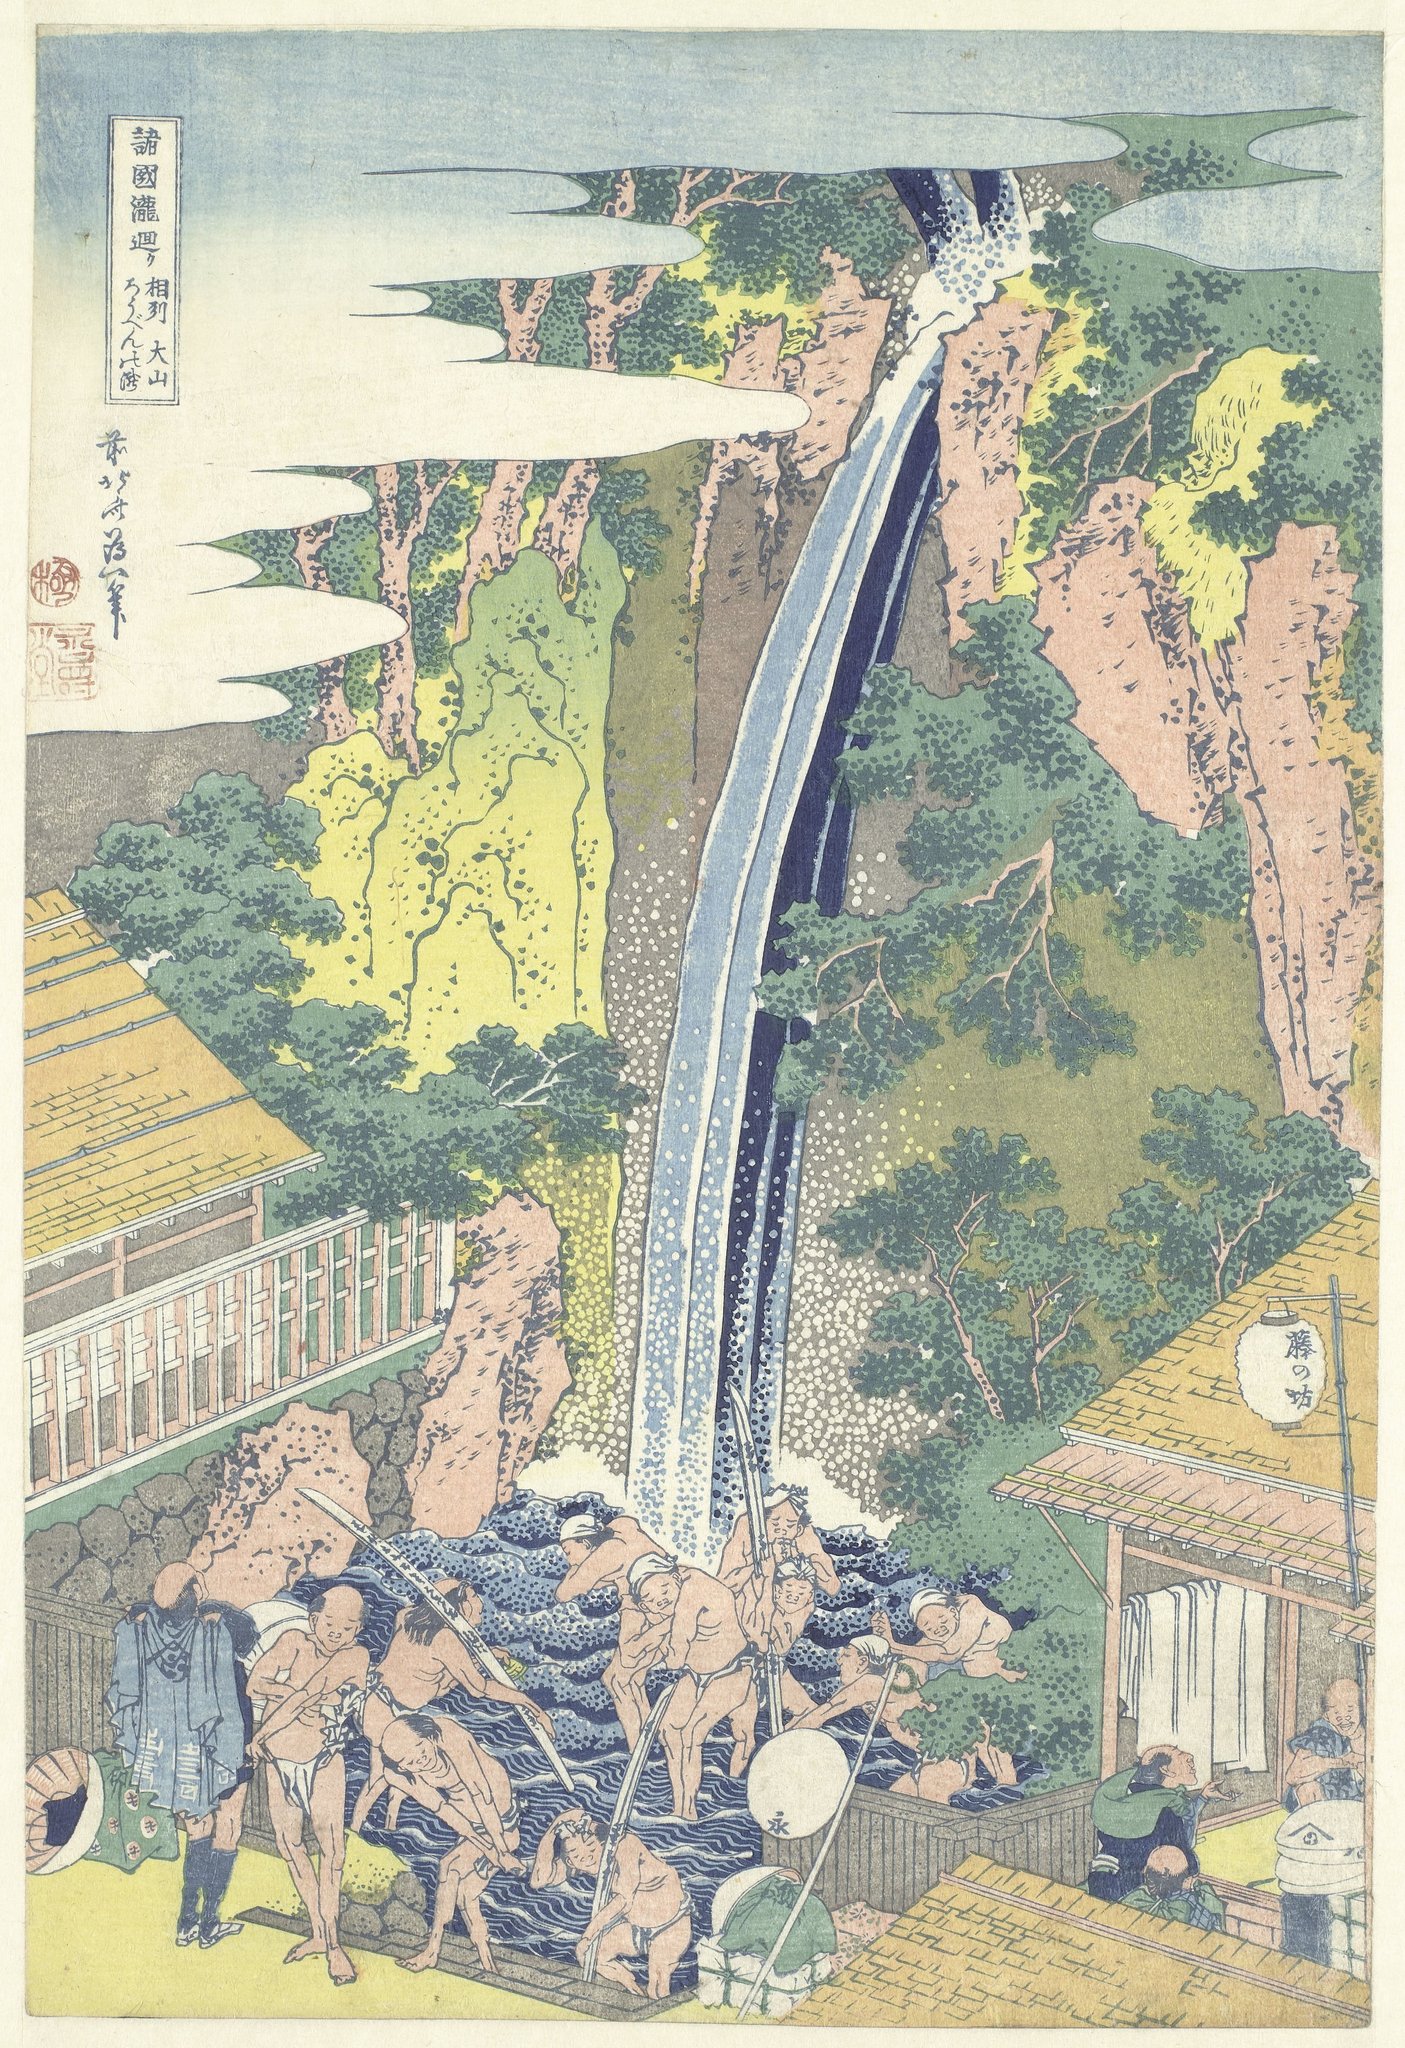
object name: print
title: Soshu Oyama Roben no taki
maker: katsushika hokusai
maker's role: draughtsman, print maker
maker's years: 1760-1849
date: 1830-1834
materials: paper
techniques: woodcut, nishiki e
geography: tokyo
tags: waterfall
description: Pelgrims badend in een poel onderaan een waterval welke neerstort vanuit de bergwand; een badhuis naast de poel.